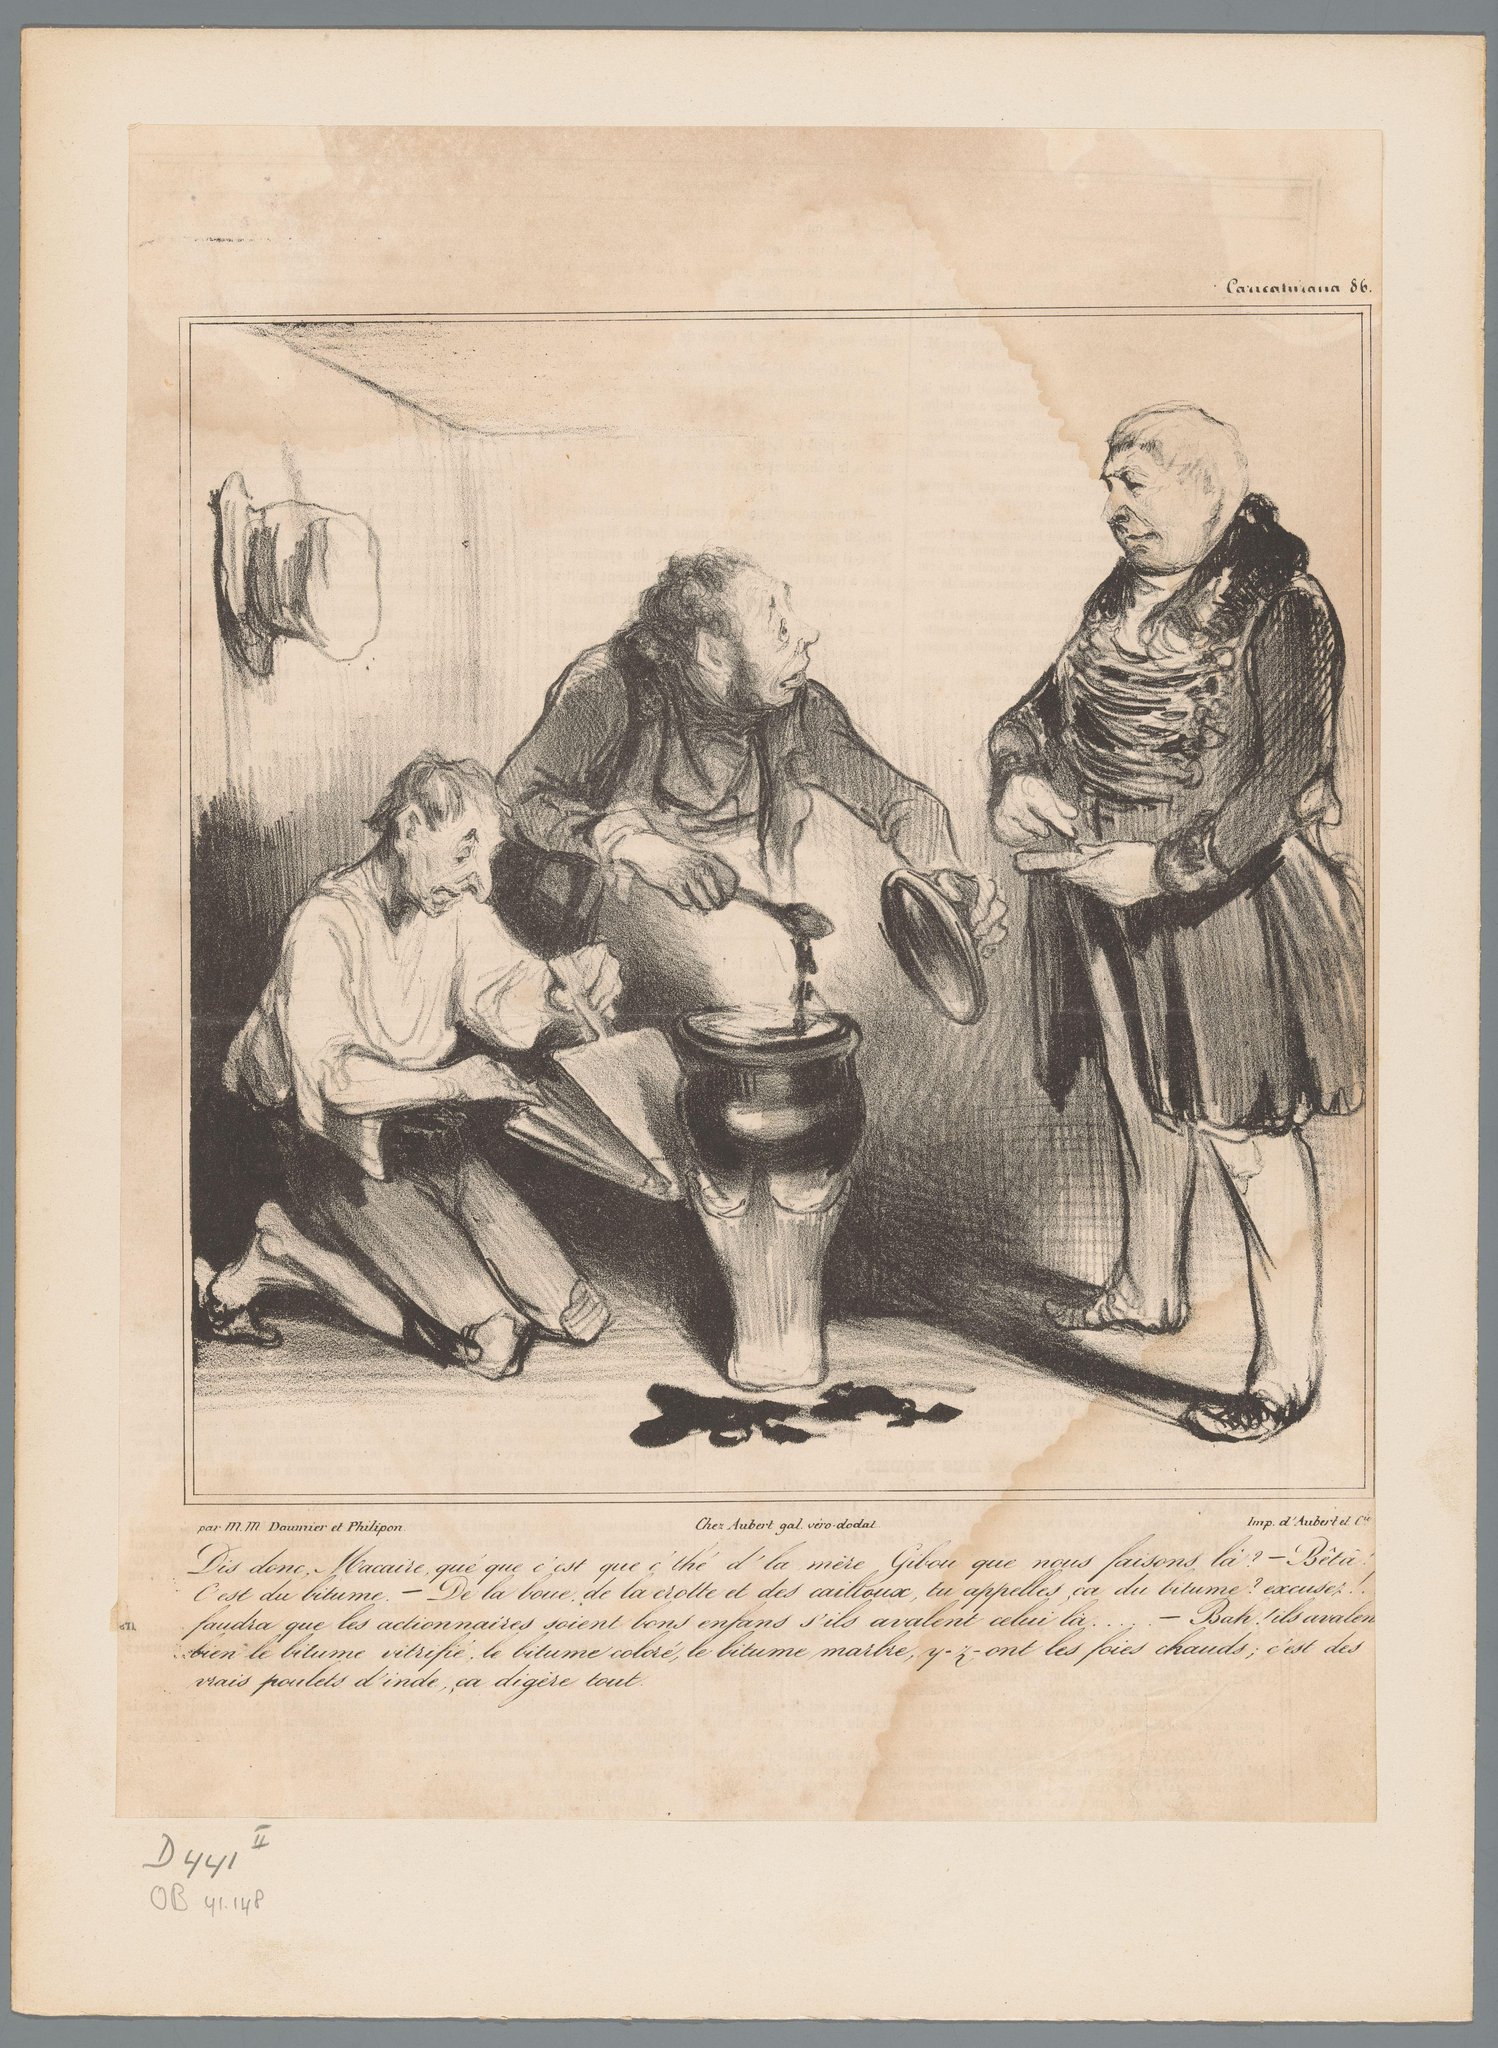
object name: cartoon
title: Caricaturana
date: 1838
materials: paper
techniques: letterpress printing, lithograph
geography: paris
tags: caricatures (human types), asphalt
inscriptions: collector's mark: Lugt 2228a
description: Prent mogelijk uit: Le Charivari, 26 juli 1838.